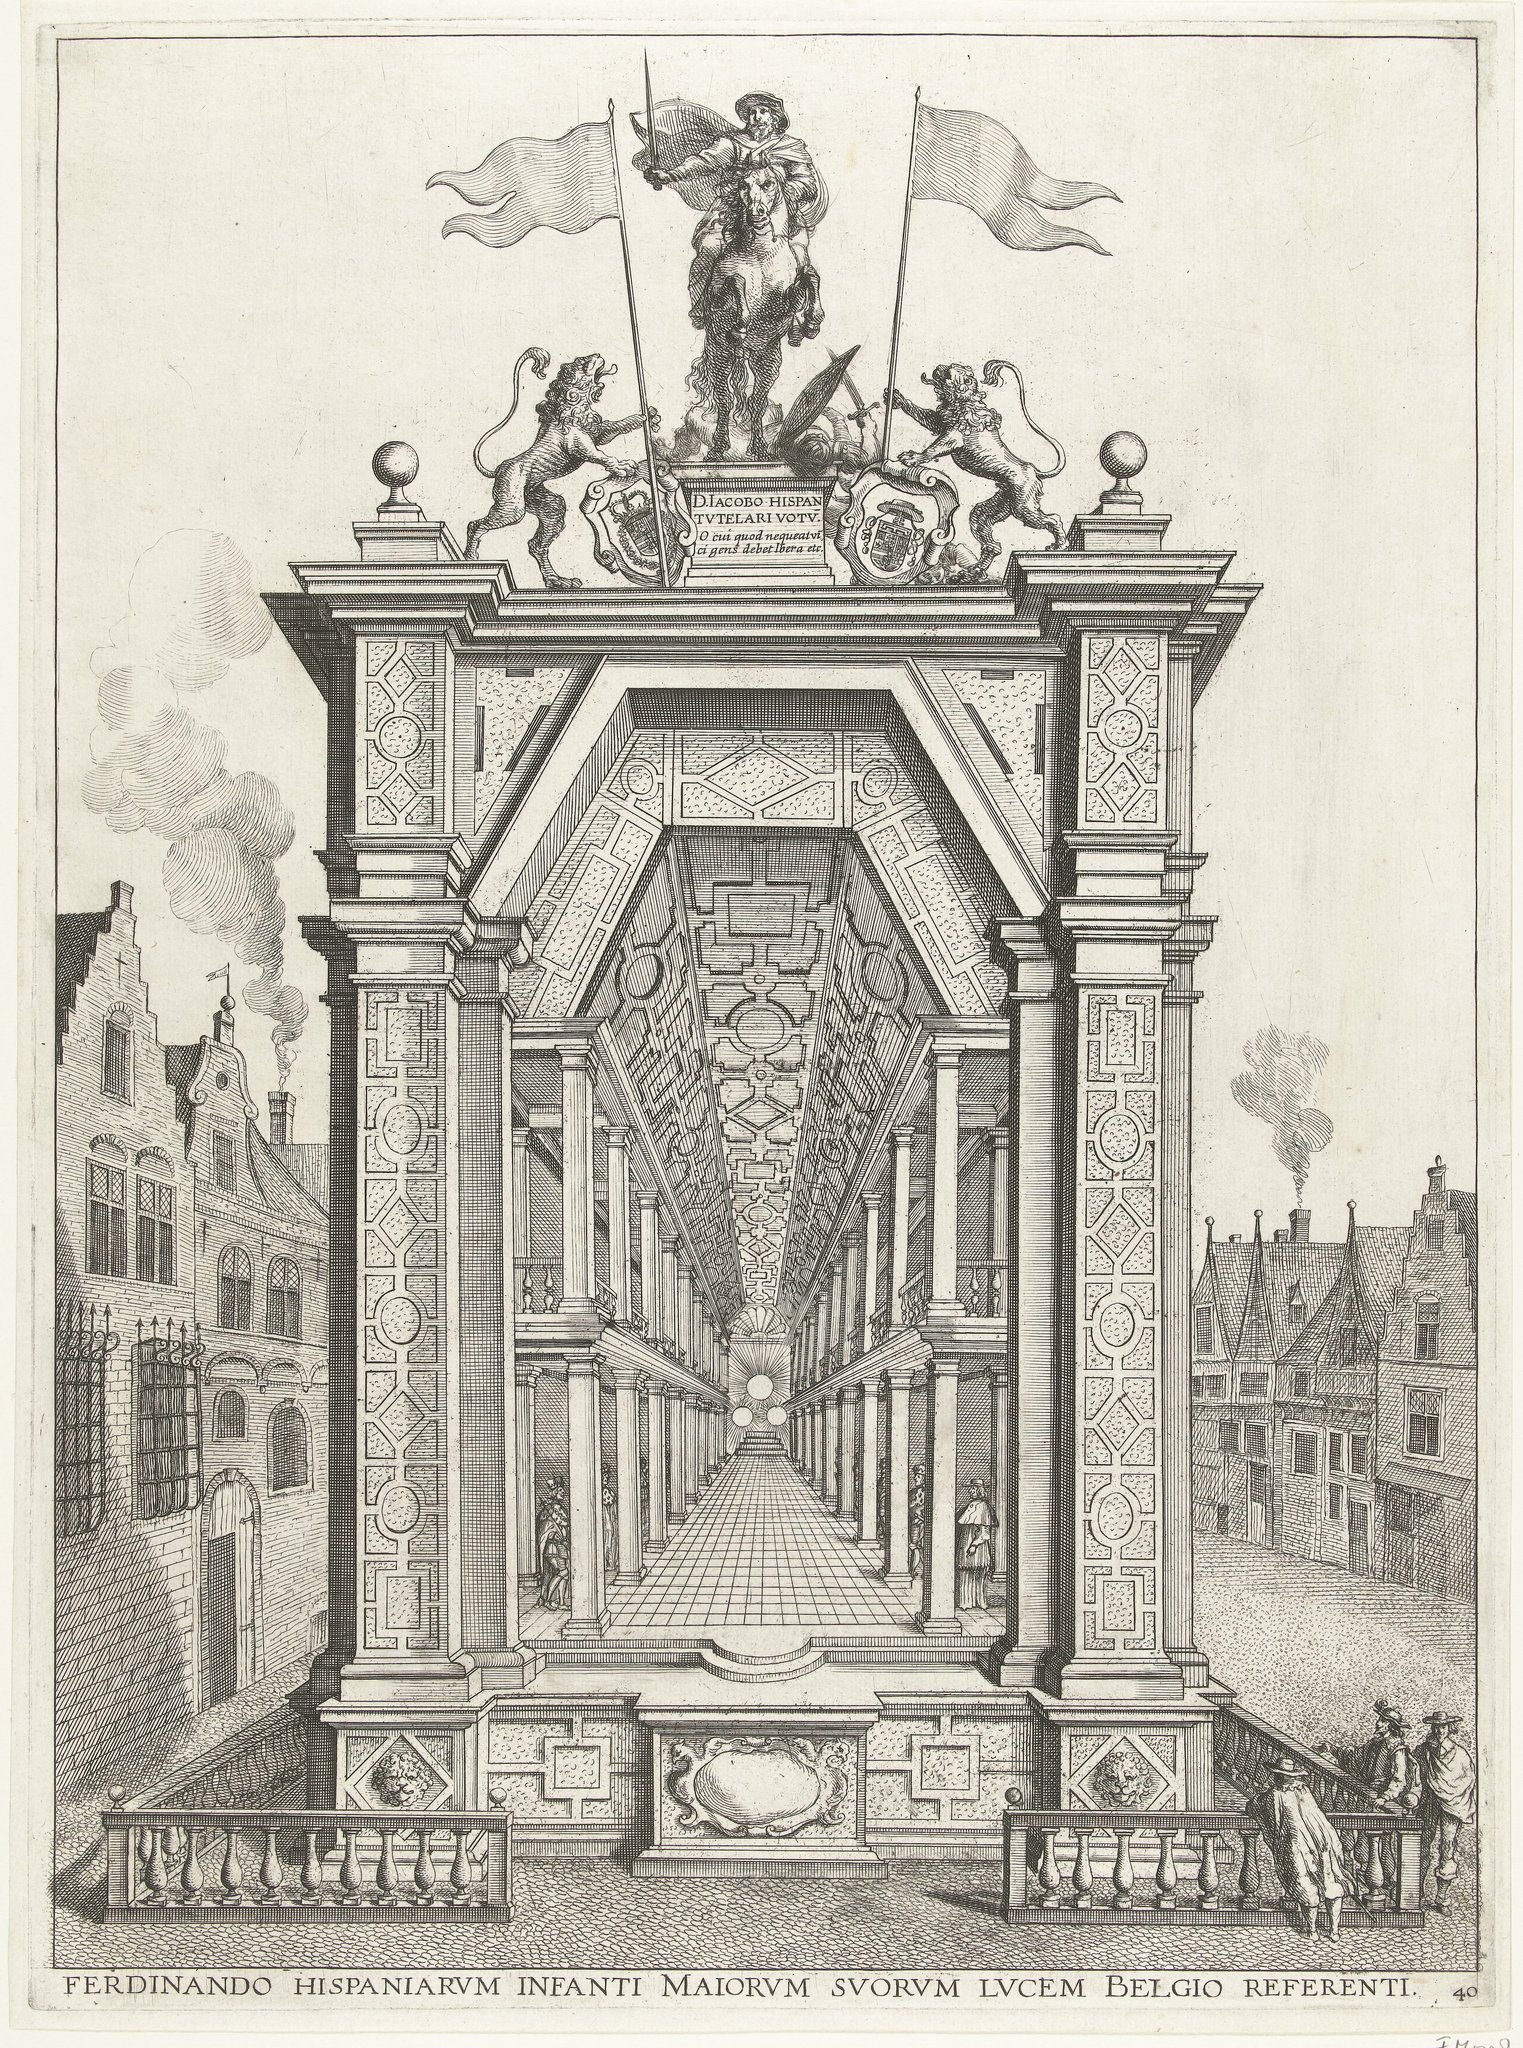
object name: print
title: Het Perspectivum; intocht van Ferdinand te Gent in 1635 (nr. 40)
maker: Anonymous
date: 1635-1636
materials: paper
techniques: engraving, etching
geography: southern netherlands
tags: brussels, landvoogd der zuidelijke nederlanden ferdinand van oostenrijk, triumphal entry and public reception, pageant, 'entrée solennelle', 'joyeuse entrée', mathematical perspective, ghent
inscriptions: collector's mark: Lugt 240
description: Het Perspectivum op het Veerleplein. Een galerij van twee verdiepingen uitgevoerd in hout, versierd met geschilderde standbeelden van Ferdinands Habsburgse voorouders. Blad nr. 40 in een geheel van 42 platen die de uitgave van de beschrijving van de intocht van de Kardinaal Infant Ferdinand van Oostenrijk te Gent op 28 januari 1635 als de nieuwe landvoogd voor de Spaanse Nederlanden illustreren.